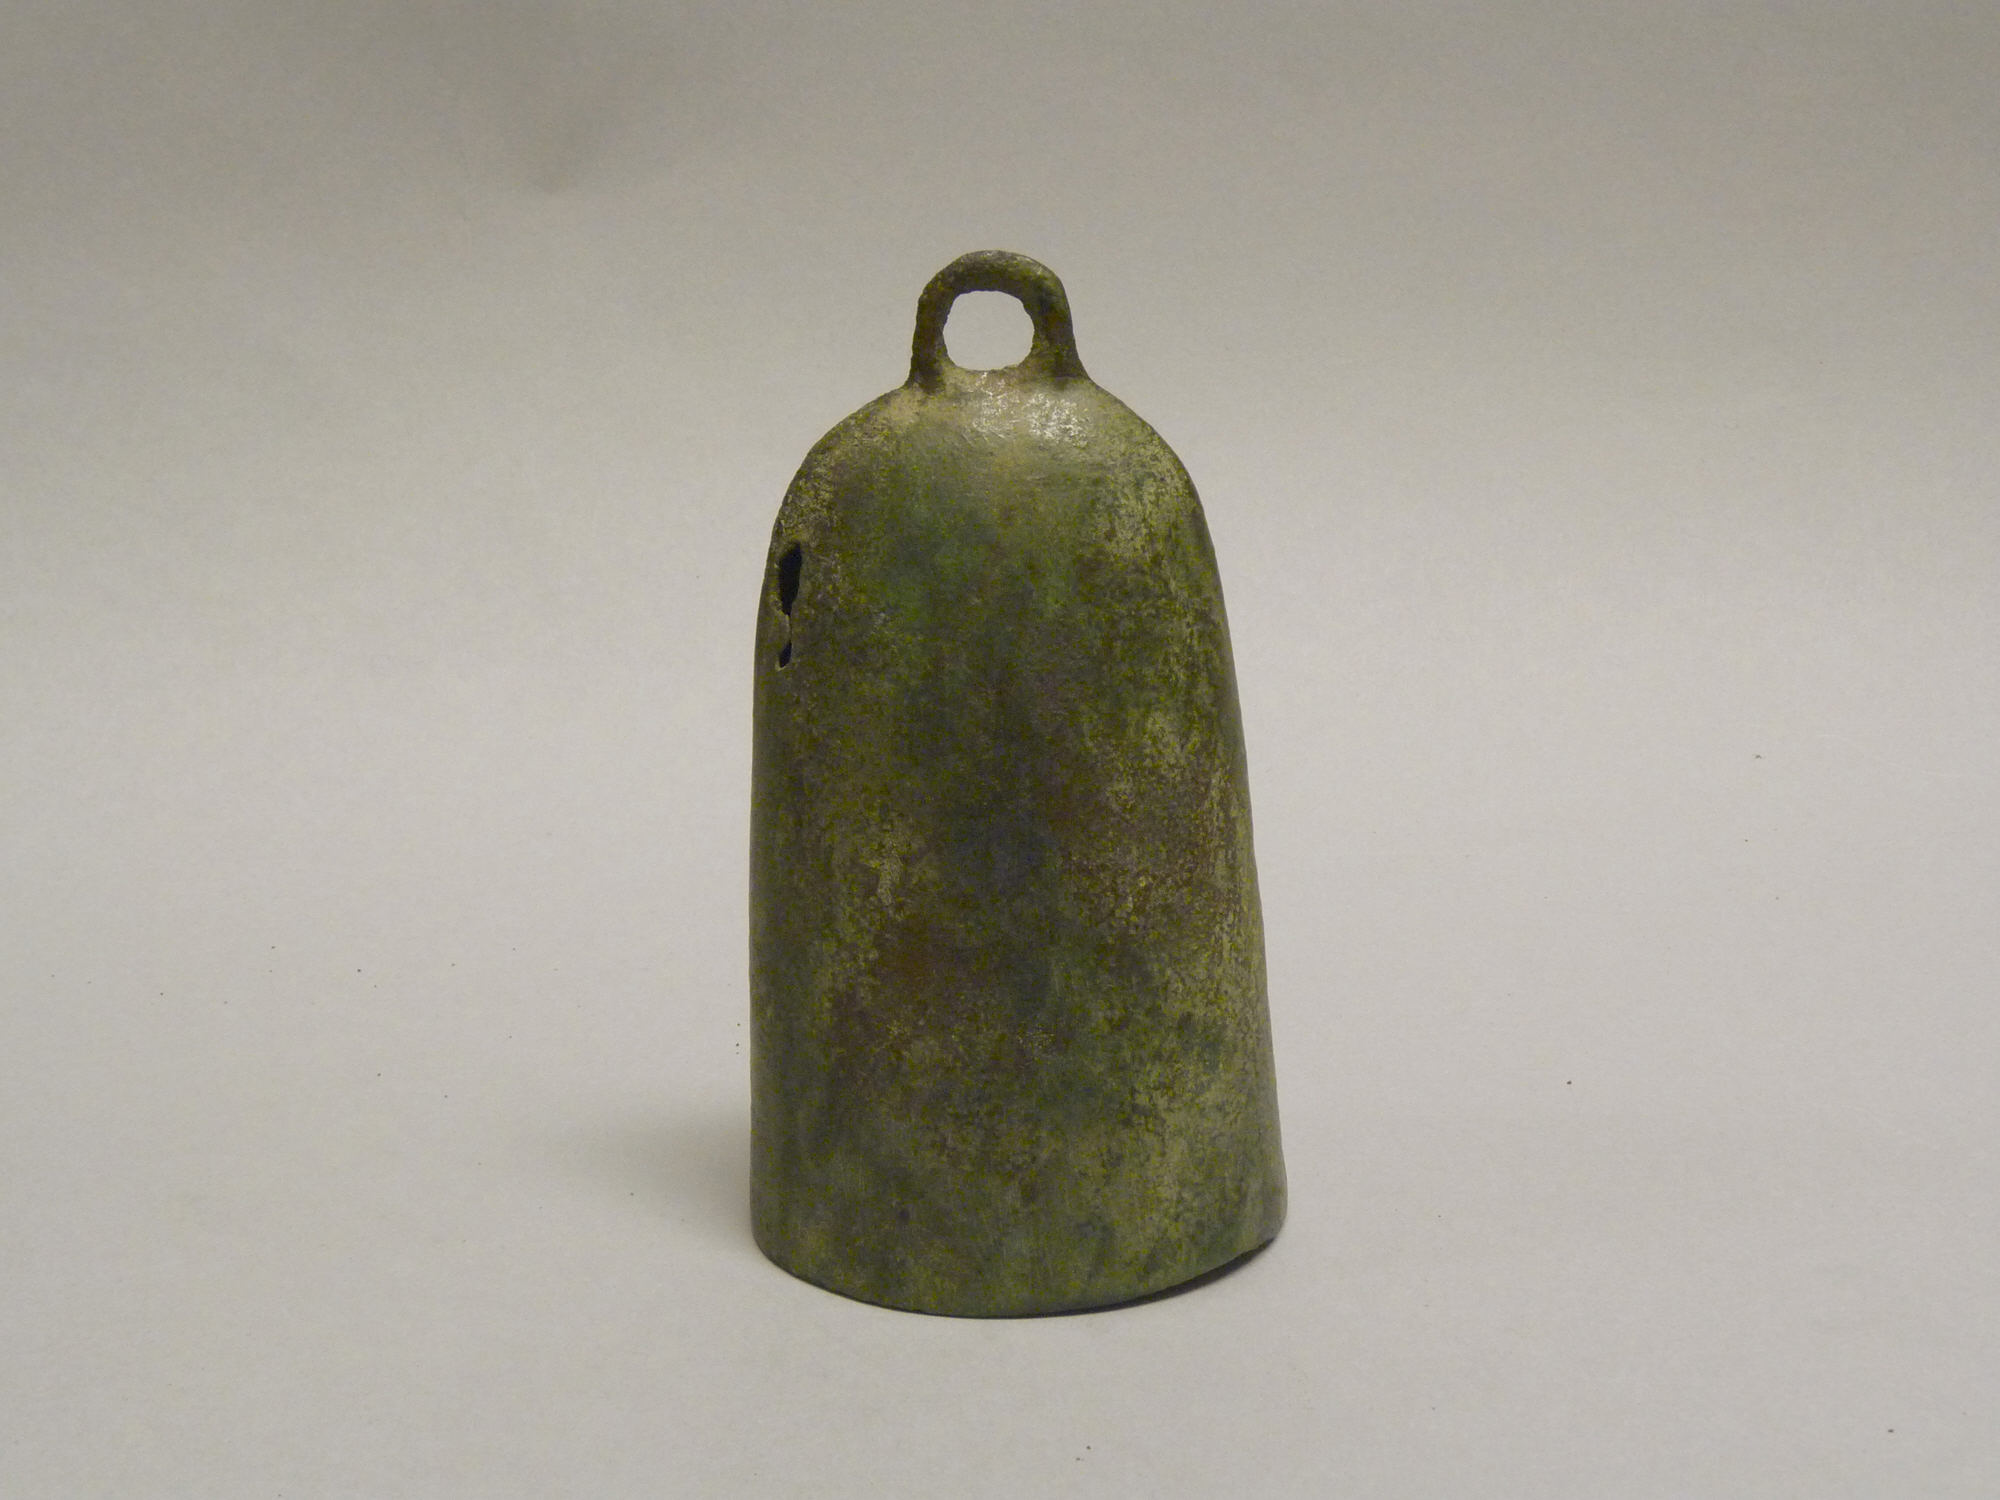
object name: bell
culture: vietnamese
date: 500 BCE-300 CE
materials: bronze